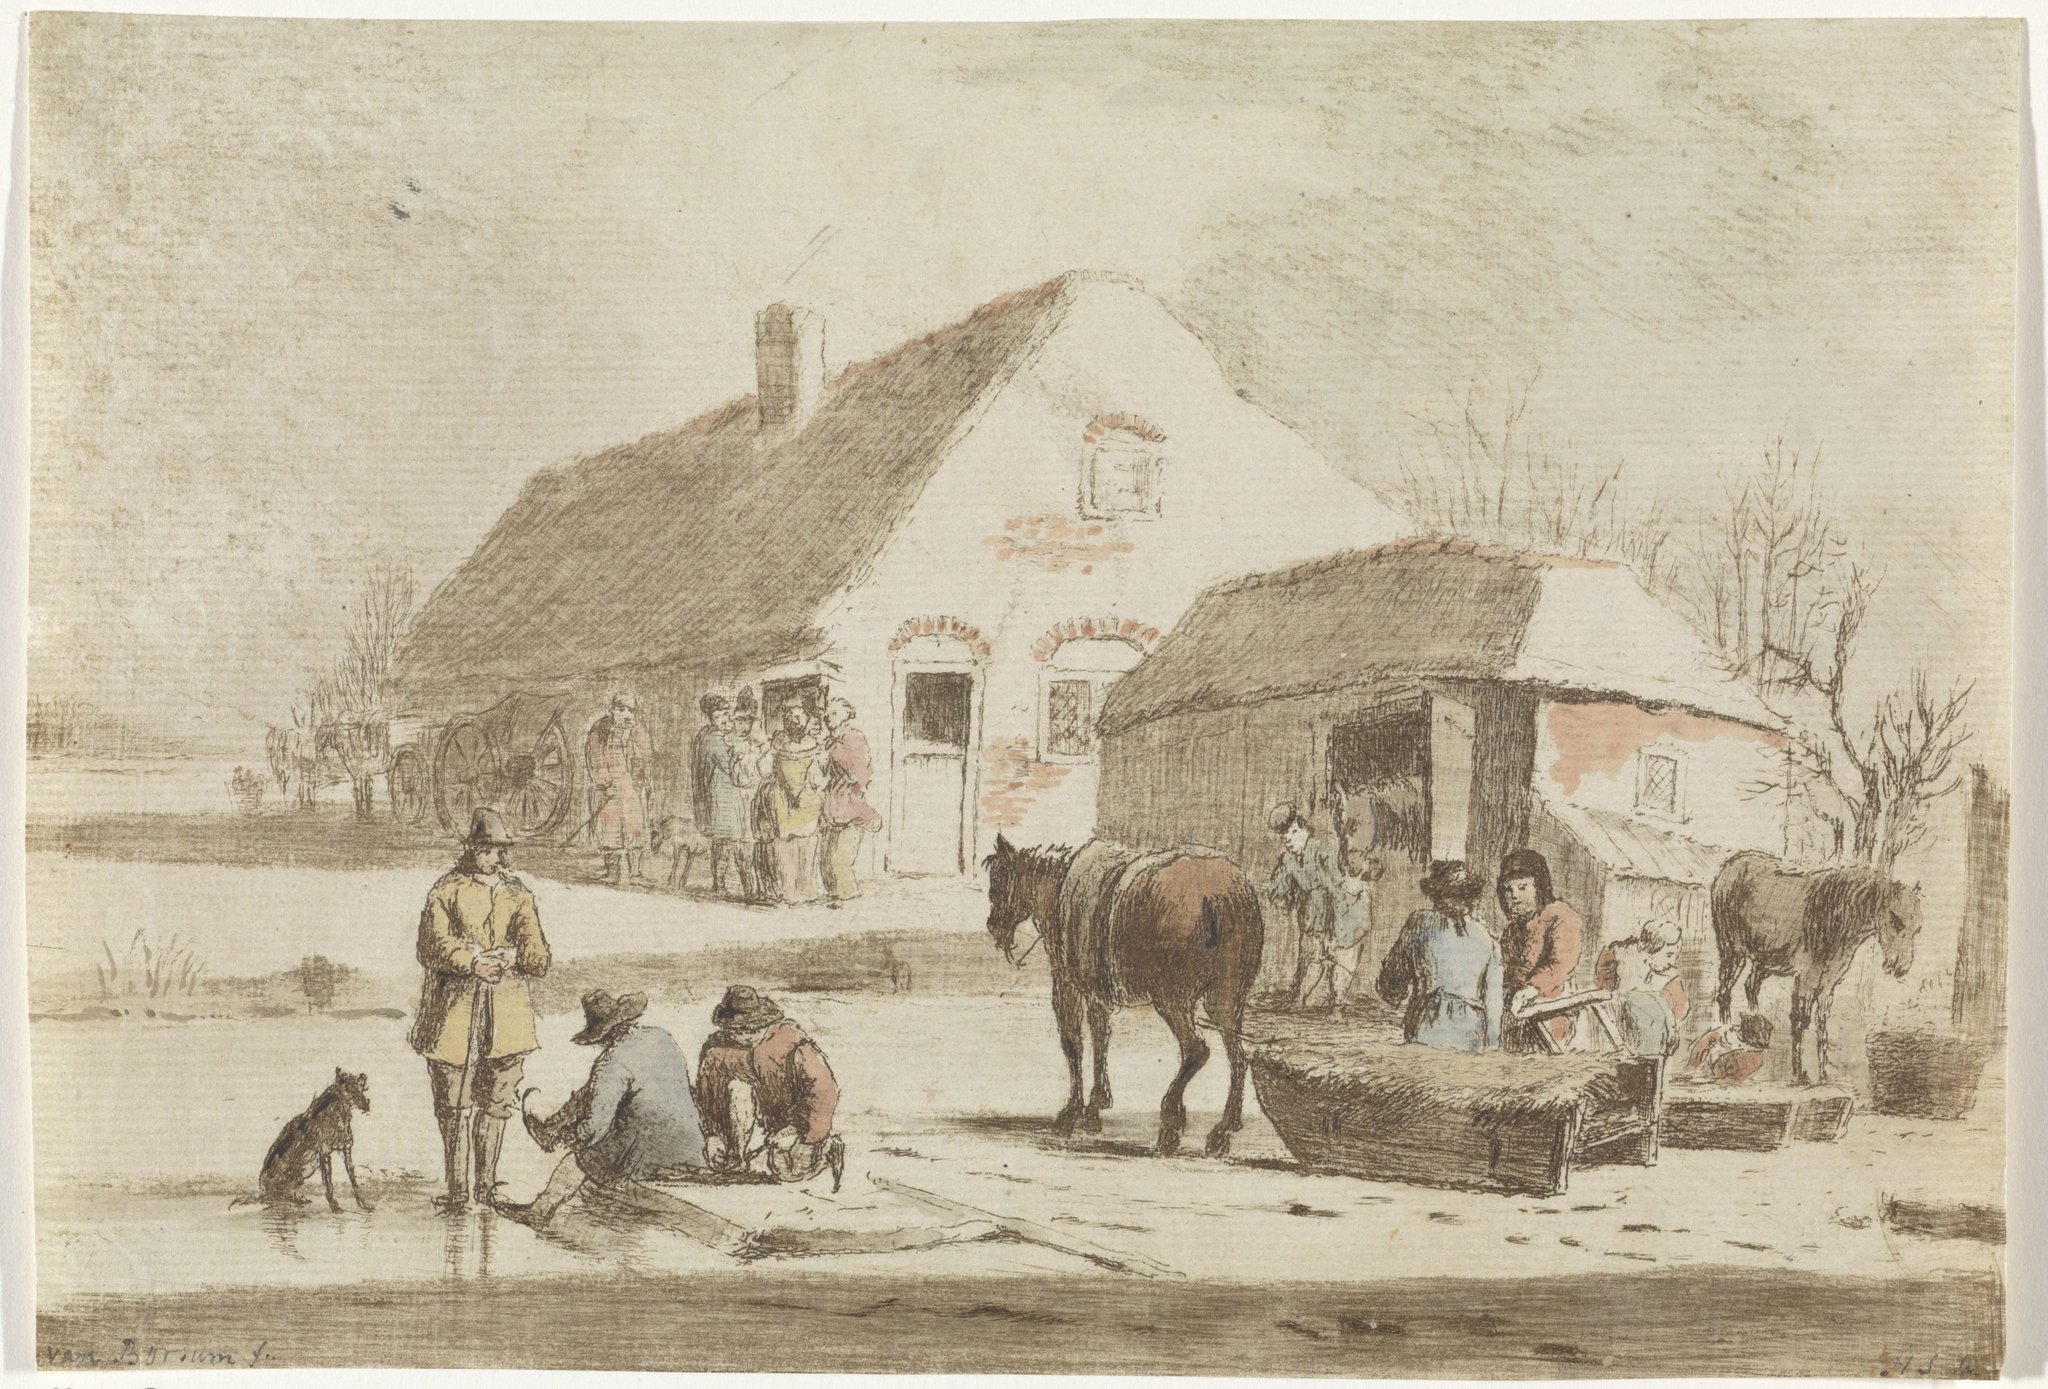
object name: print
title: Schaatsenrijders en een slede bij een boerderij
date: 1742-1784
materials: paper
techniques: etching, hand coloring, roulette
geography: haarlem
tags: skates (winter sports), sledge, sleigh (winter sports), farm or solitary house in landscape (+ city(-scape) with figures, staffage)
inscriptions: collector's mark: Lugt 2228